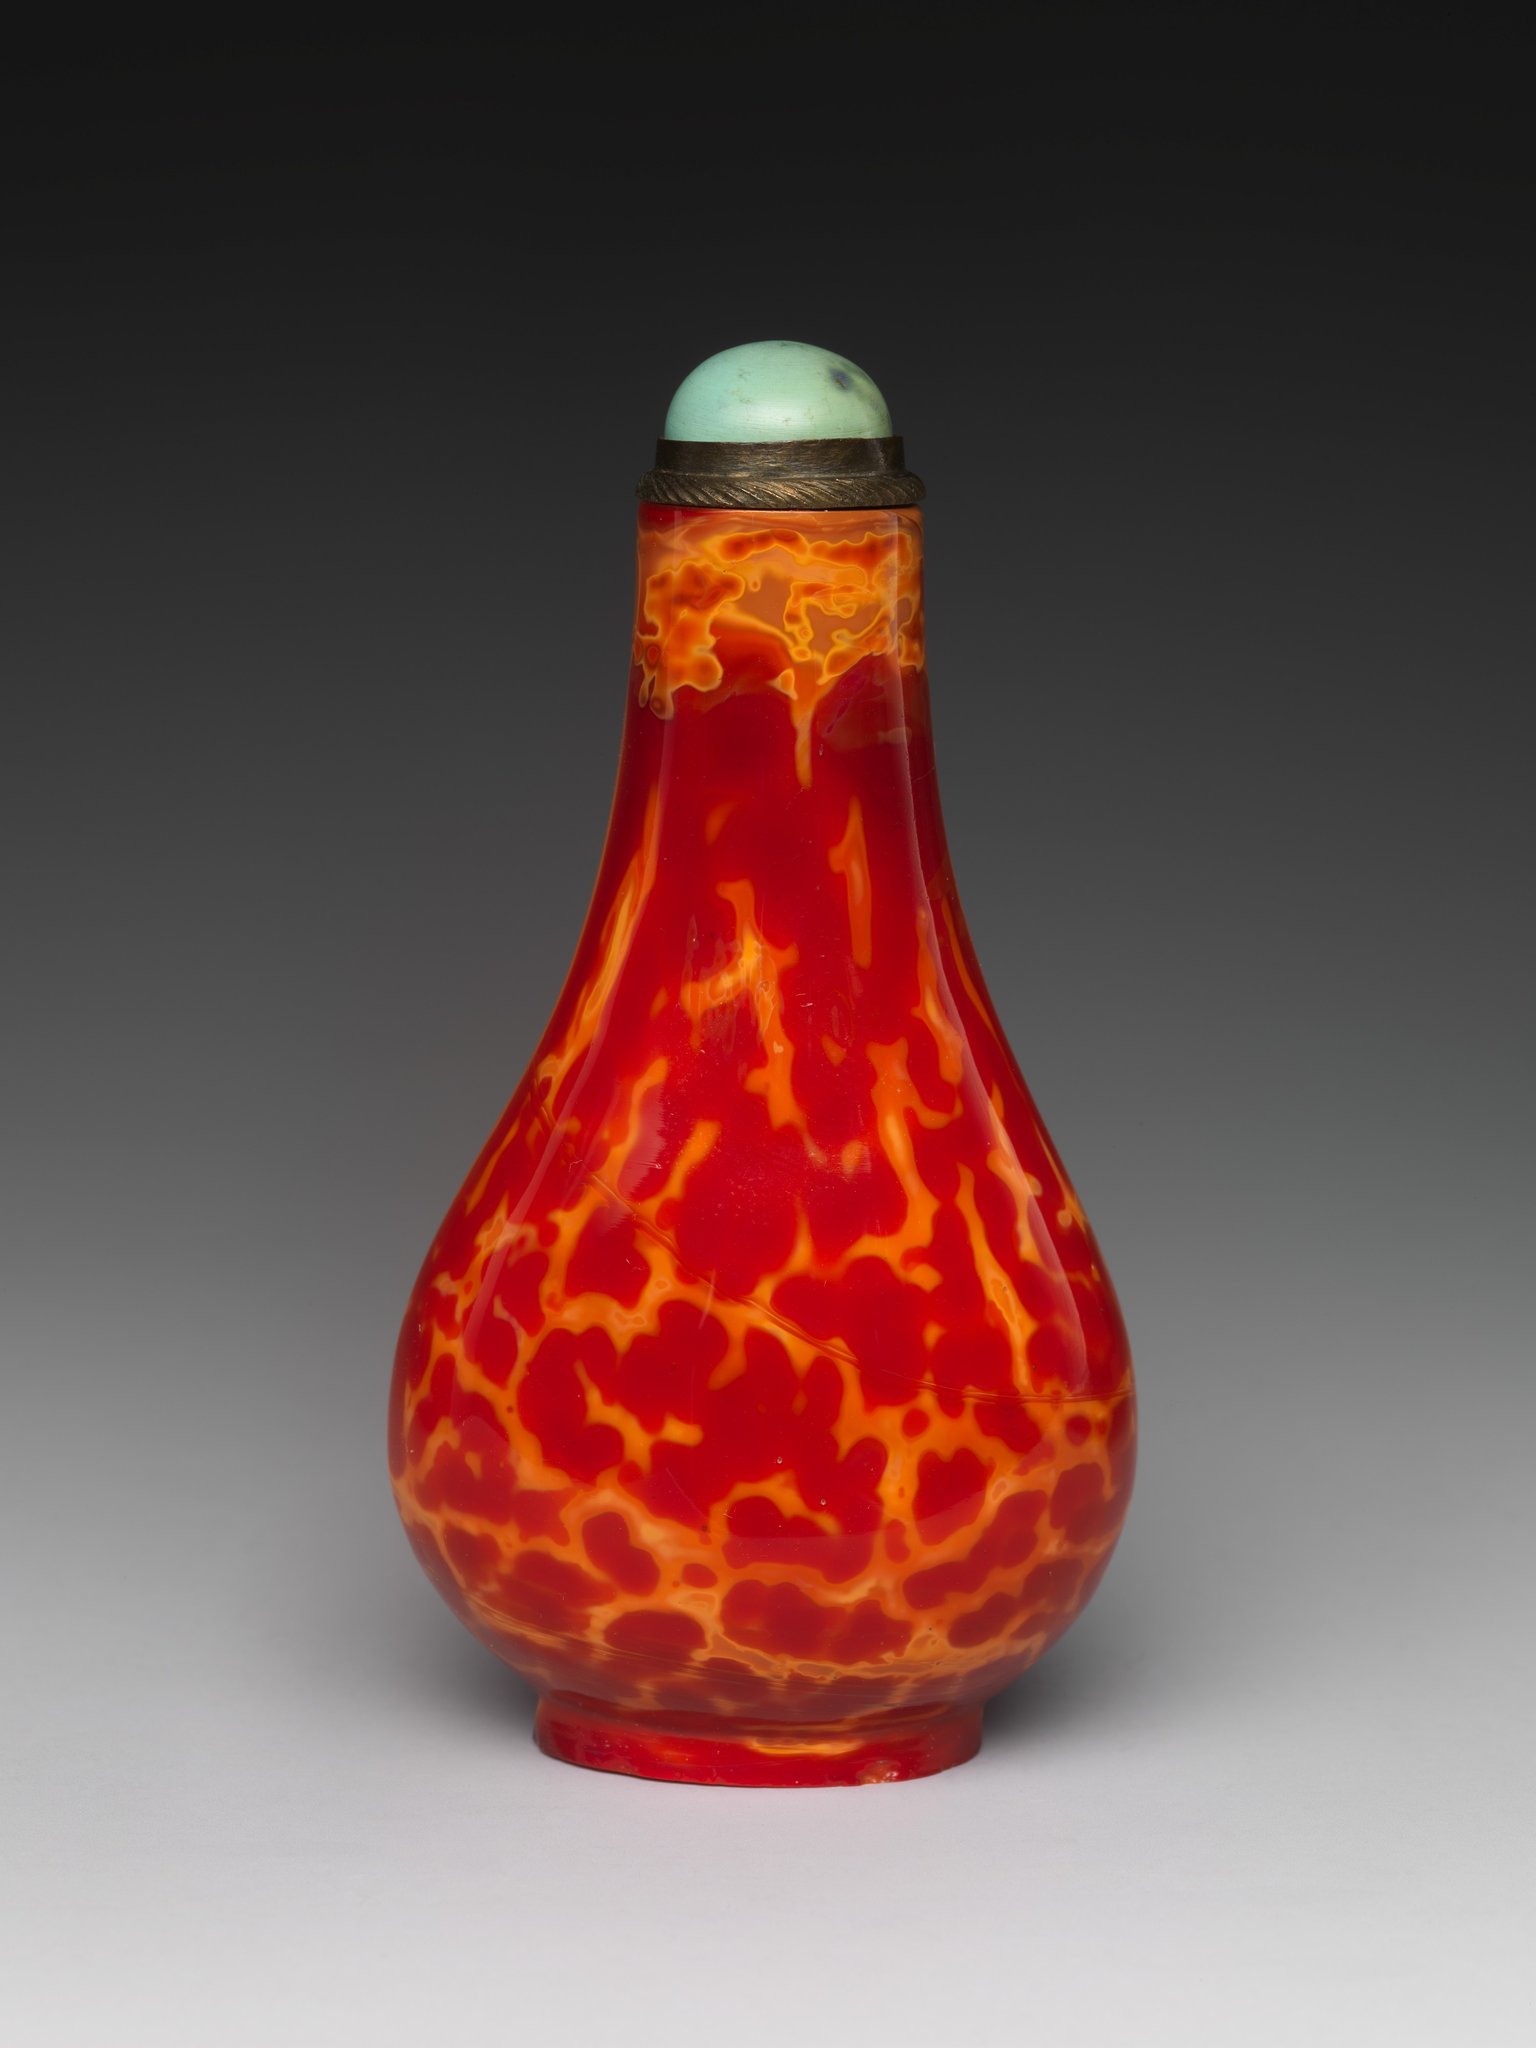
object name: snuff bottle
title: Snuff Bottle in Simulated Realgar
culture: chinese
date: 1767-1800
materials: glass